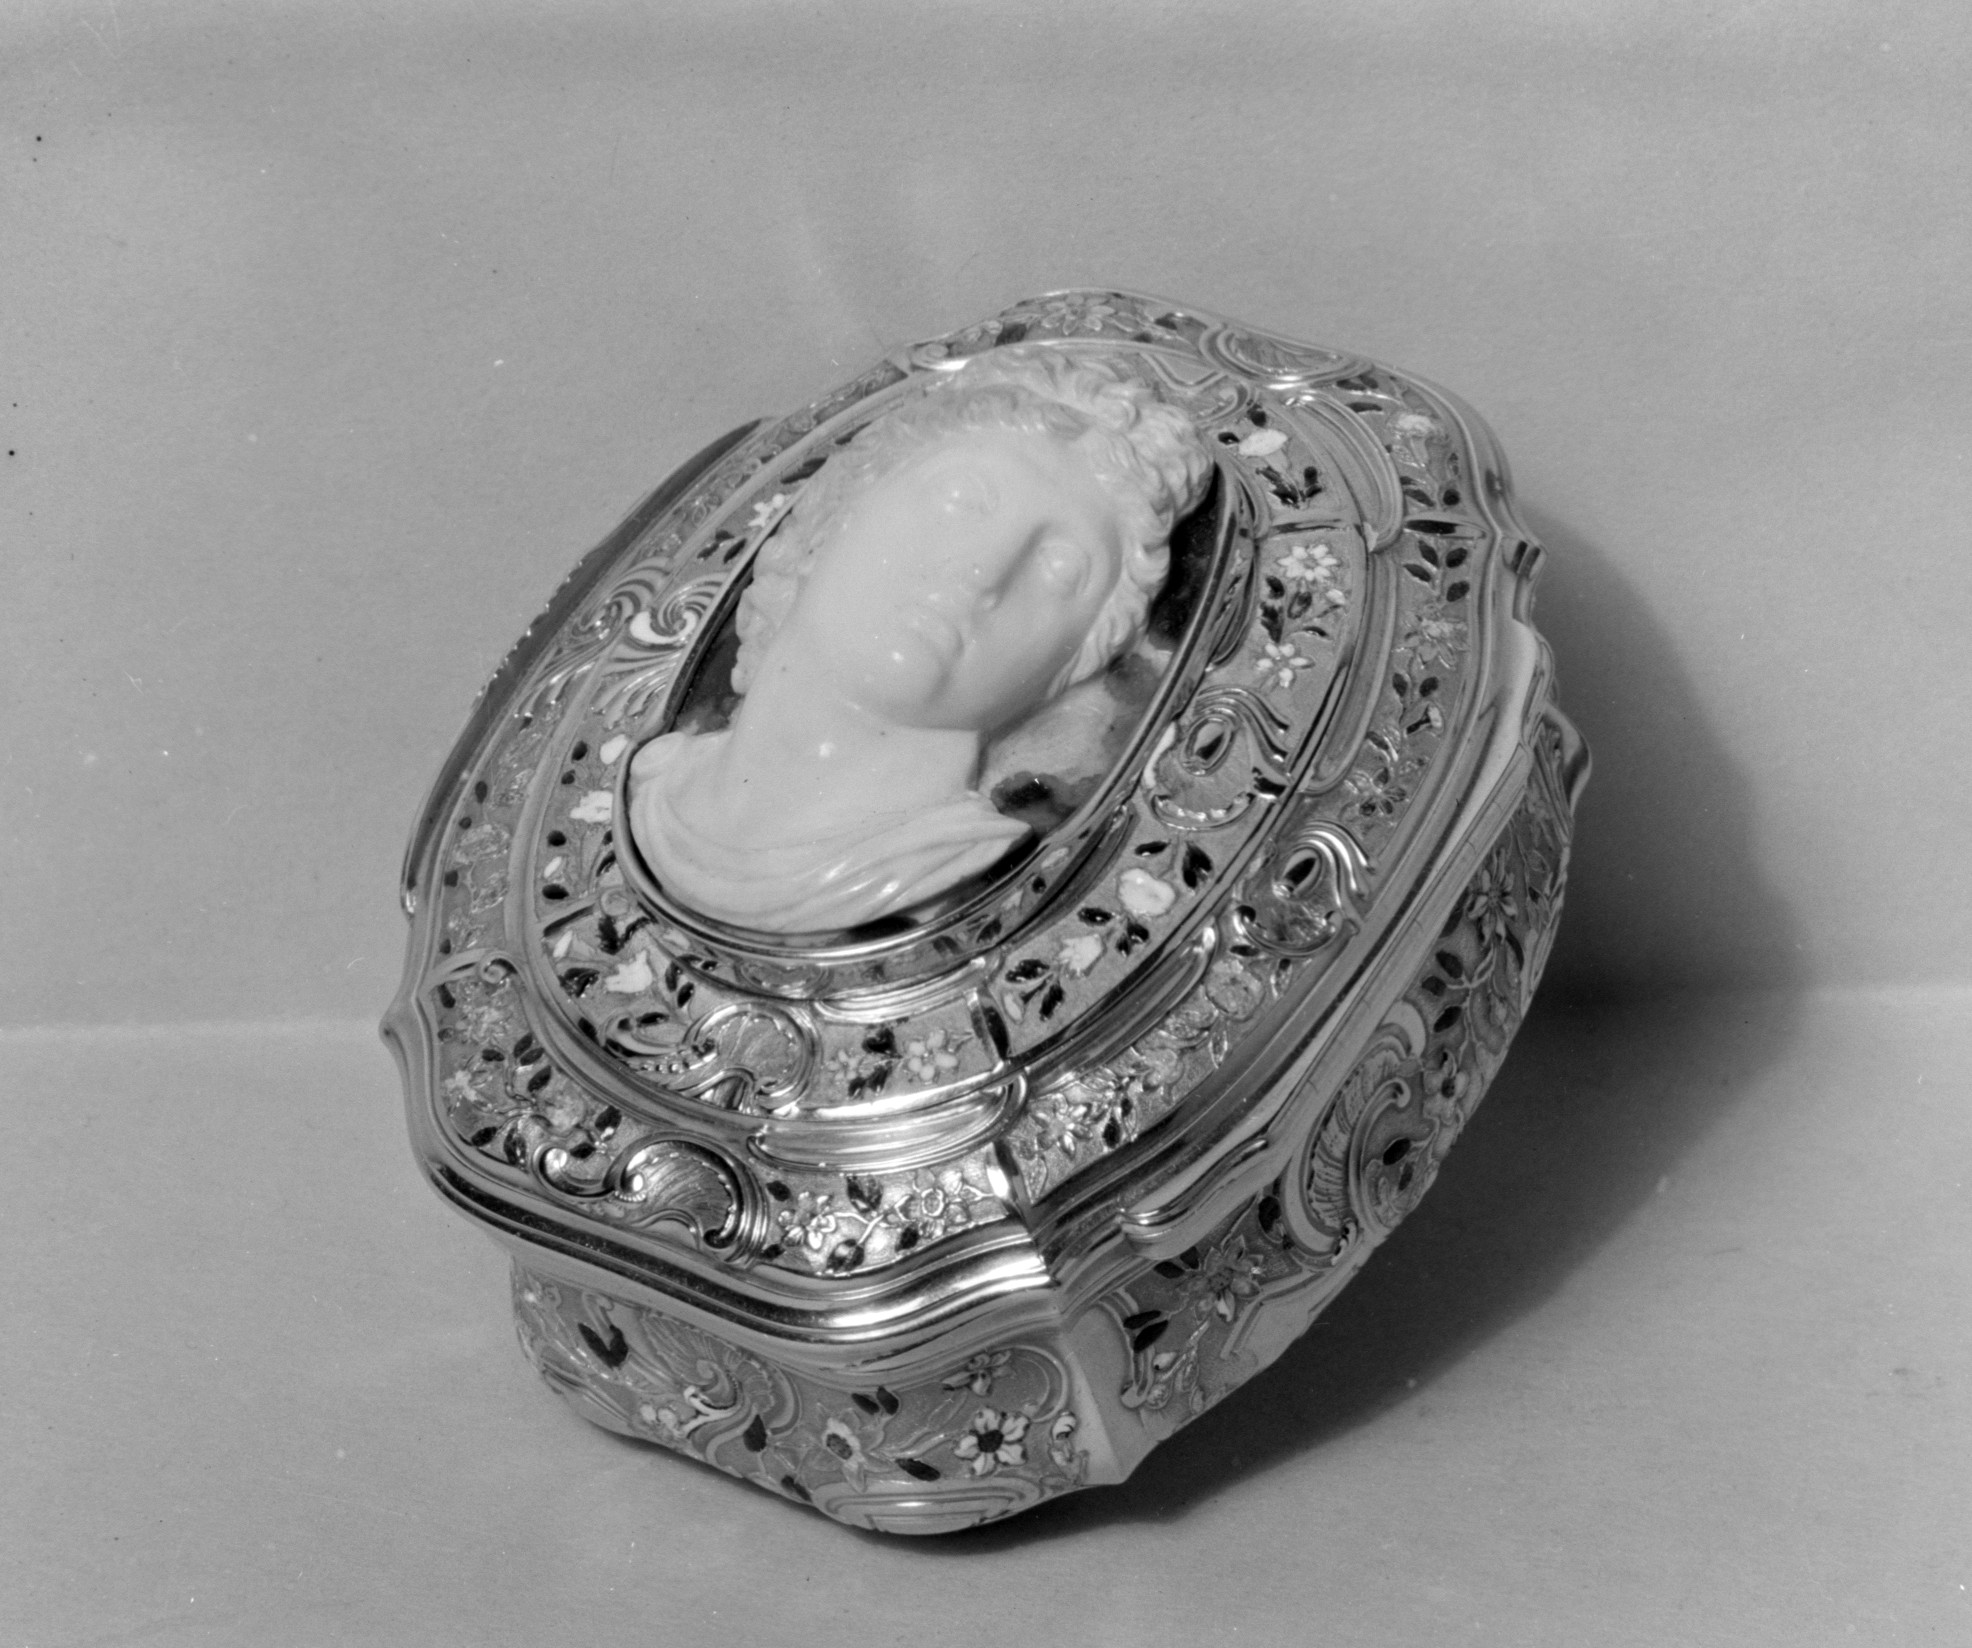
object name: snuffbox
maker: noel-charles laget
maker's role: maker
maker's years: 1698-1789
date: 1738-1739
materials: stone, enamel, gold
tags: men